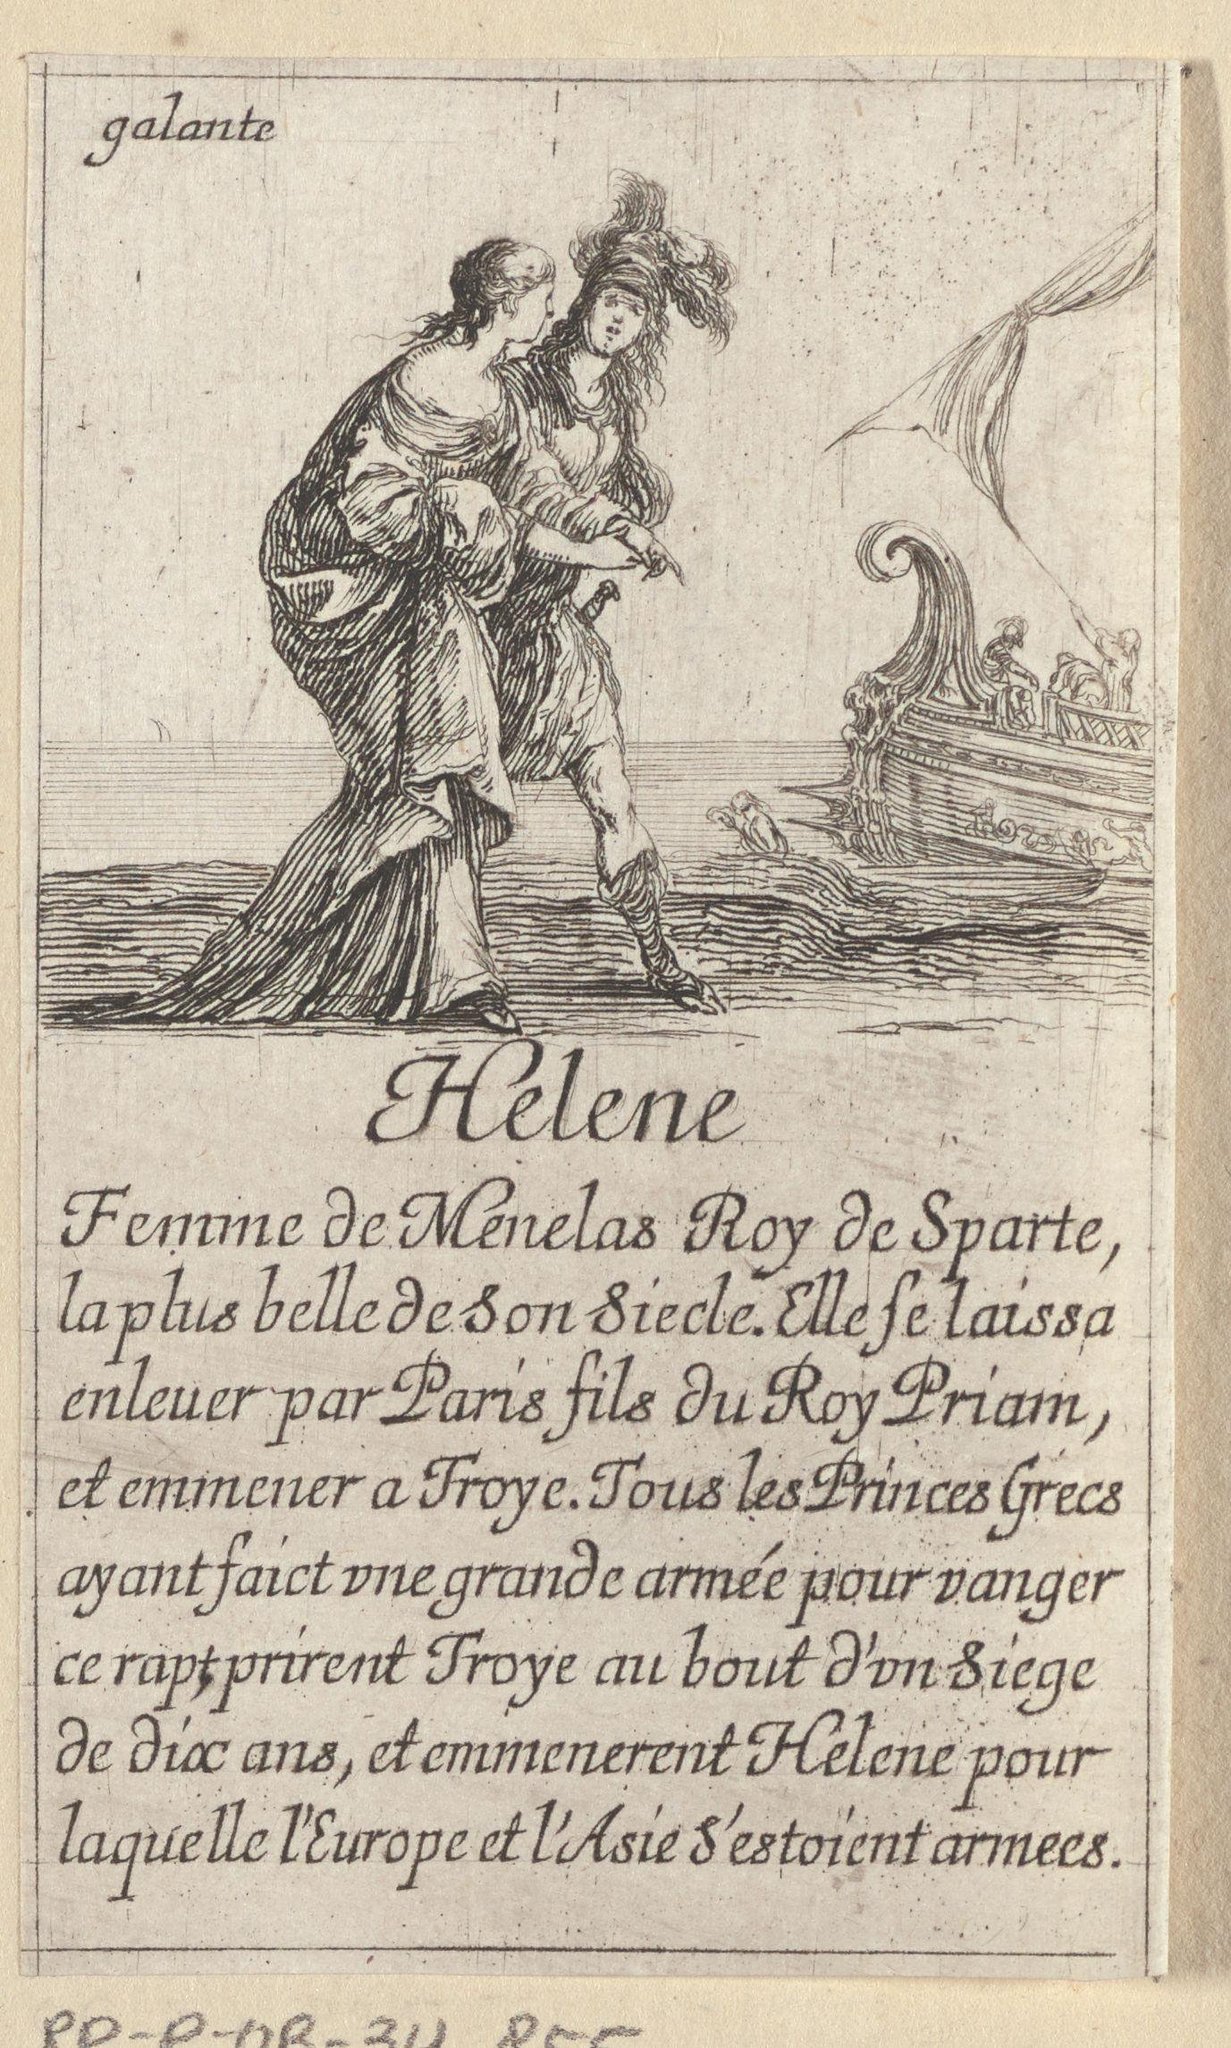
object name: print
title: Jeu des reynes renommées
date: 1620-1664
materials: paper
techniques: etching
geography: paris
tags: empress helena, mother of constantine the great; possible attributes: model of church, (royal) crown, crown of thorns, cross, three nails, ruler, sovereign - bb - female ruler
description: Deze prent maakt deel uit van een kaartspel met 52 kaarten met voorstellingen van beroemde koninginnen. De serie is uitgedacht door Jean Desmarests de Saint-Sorlin in opdracht van Kardinaal Mazarin. Het kaartspel werd gemaakt voor de jonge Lodewijk XIV, samen met het Jeu des Fables, Jeu de la Géographie en Jeu des Rois de France.